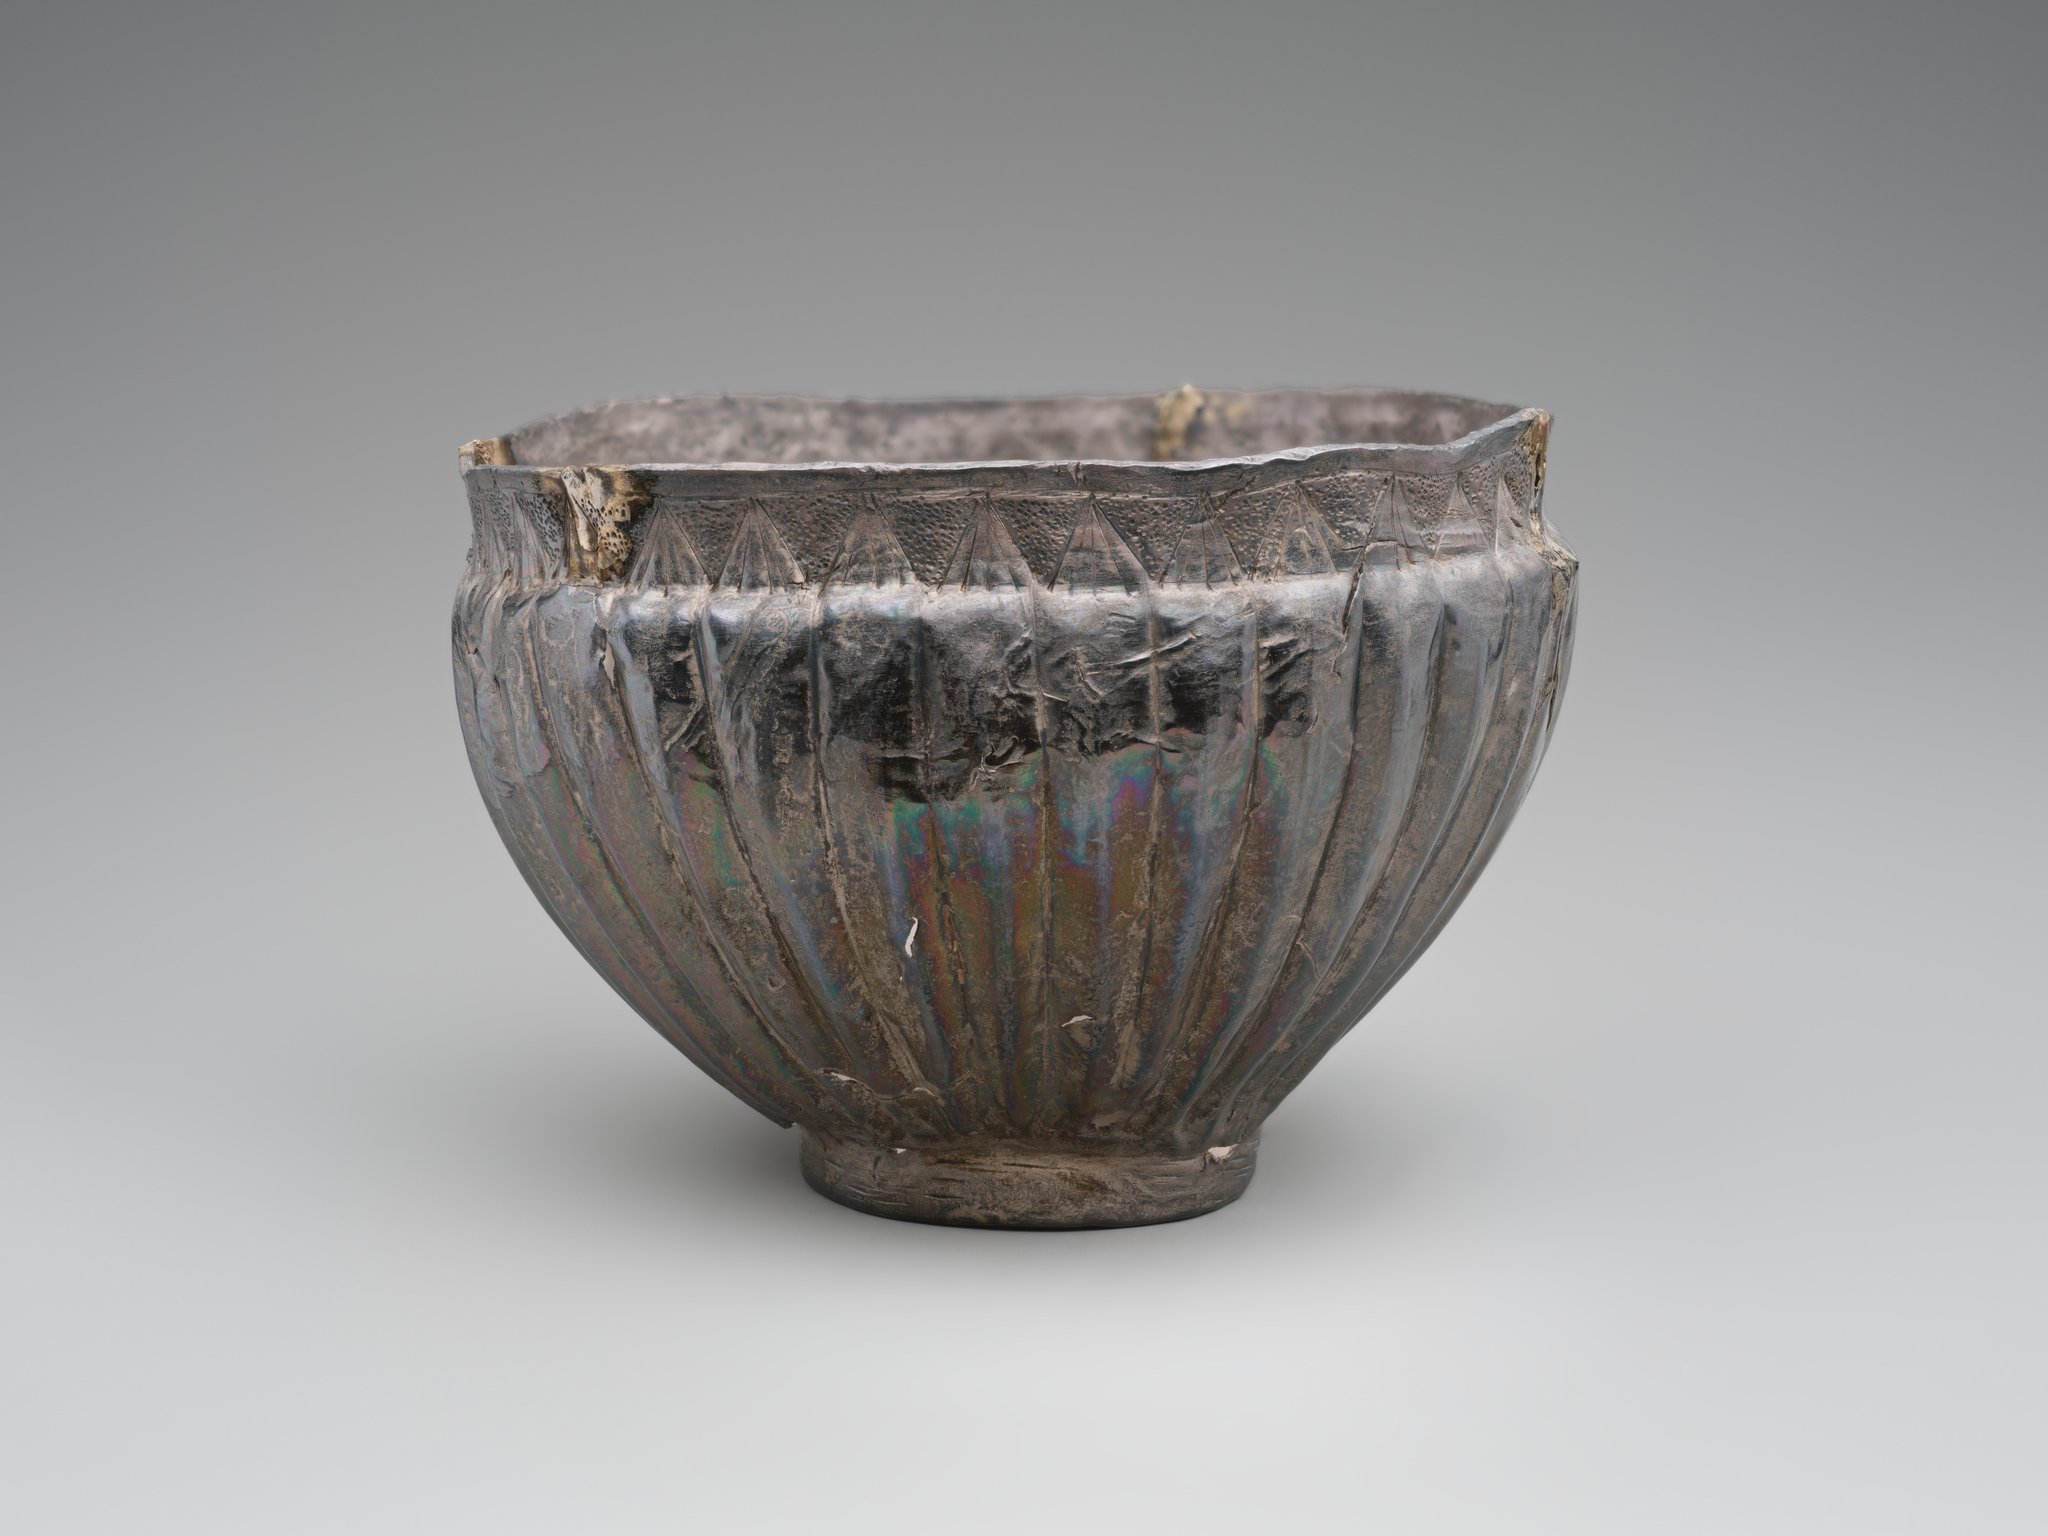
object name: cup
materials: silver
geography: syria